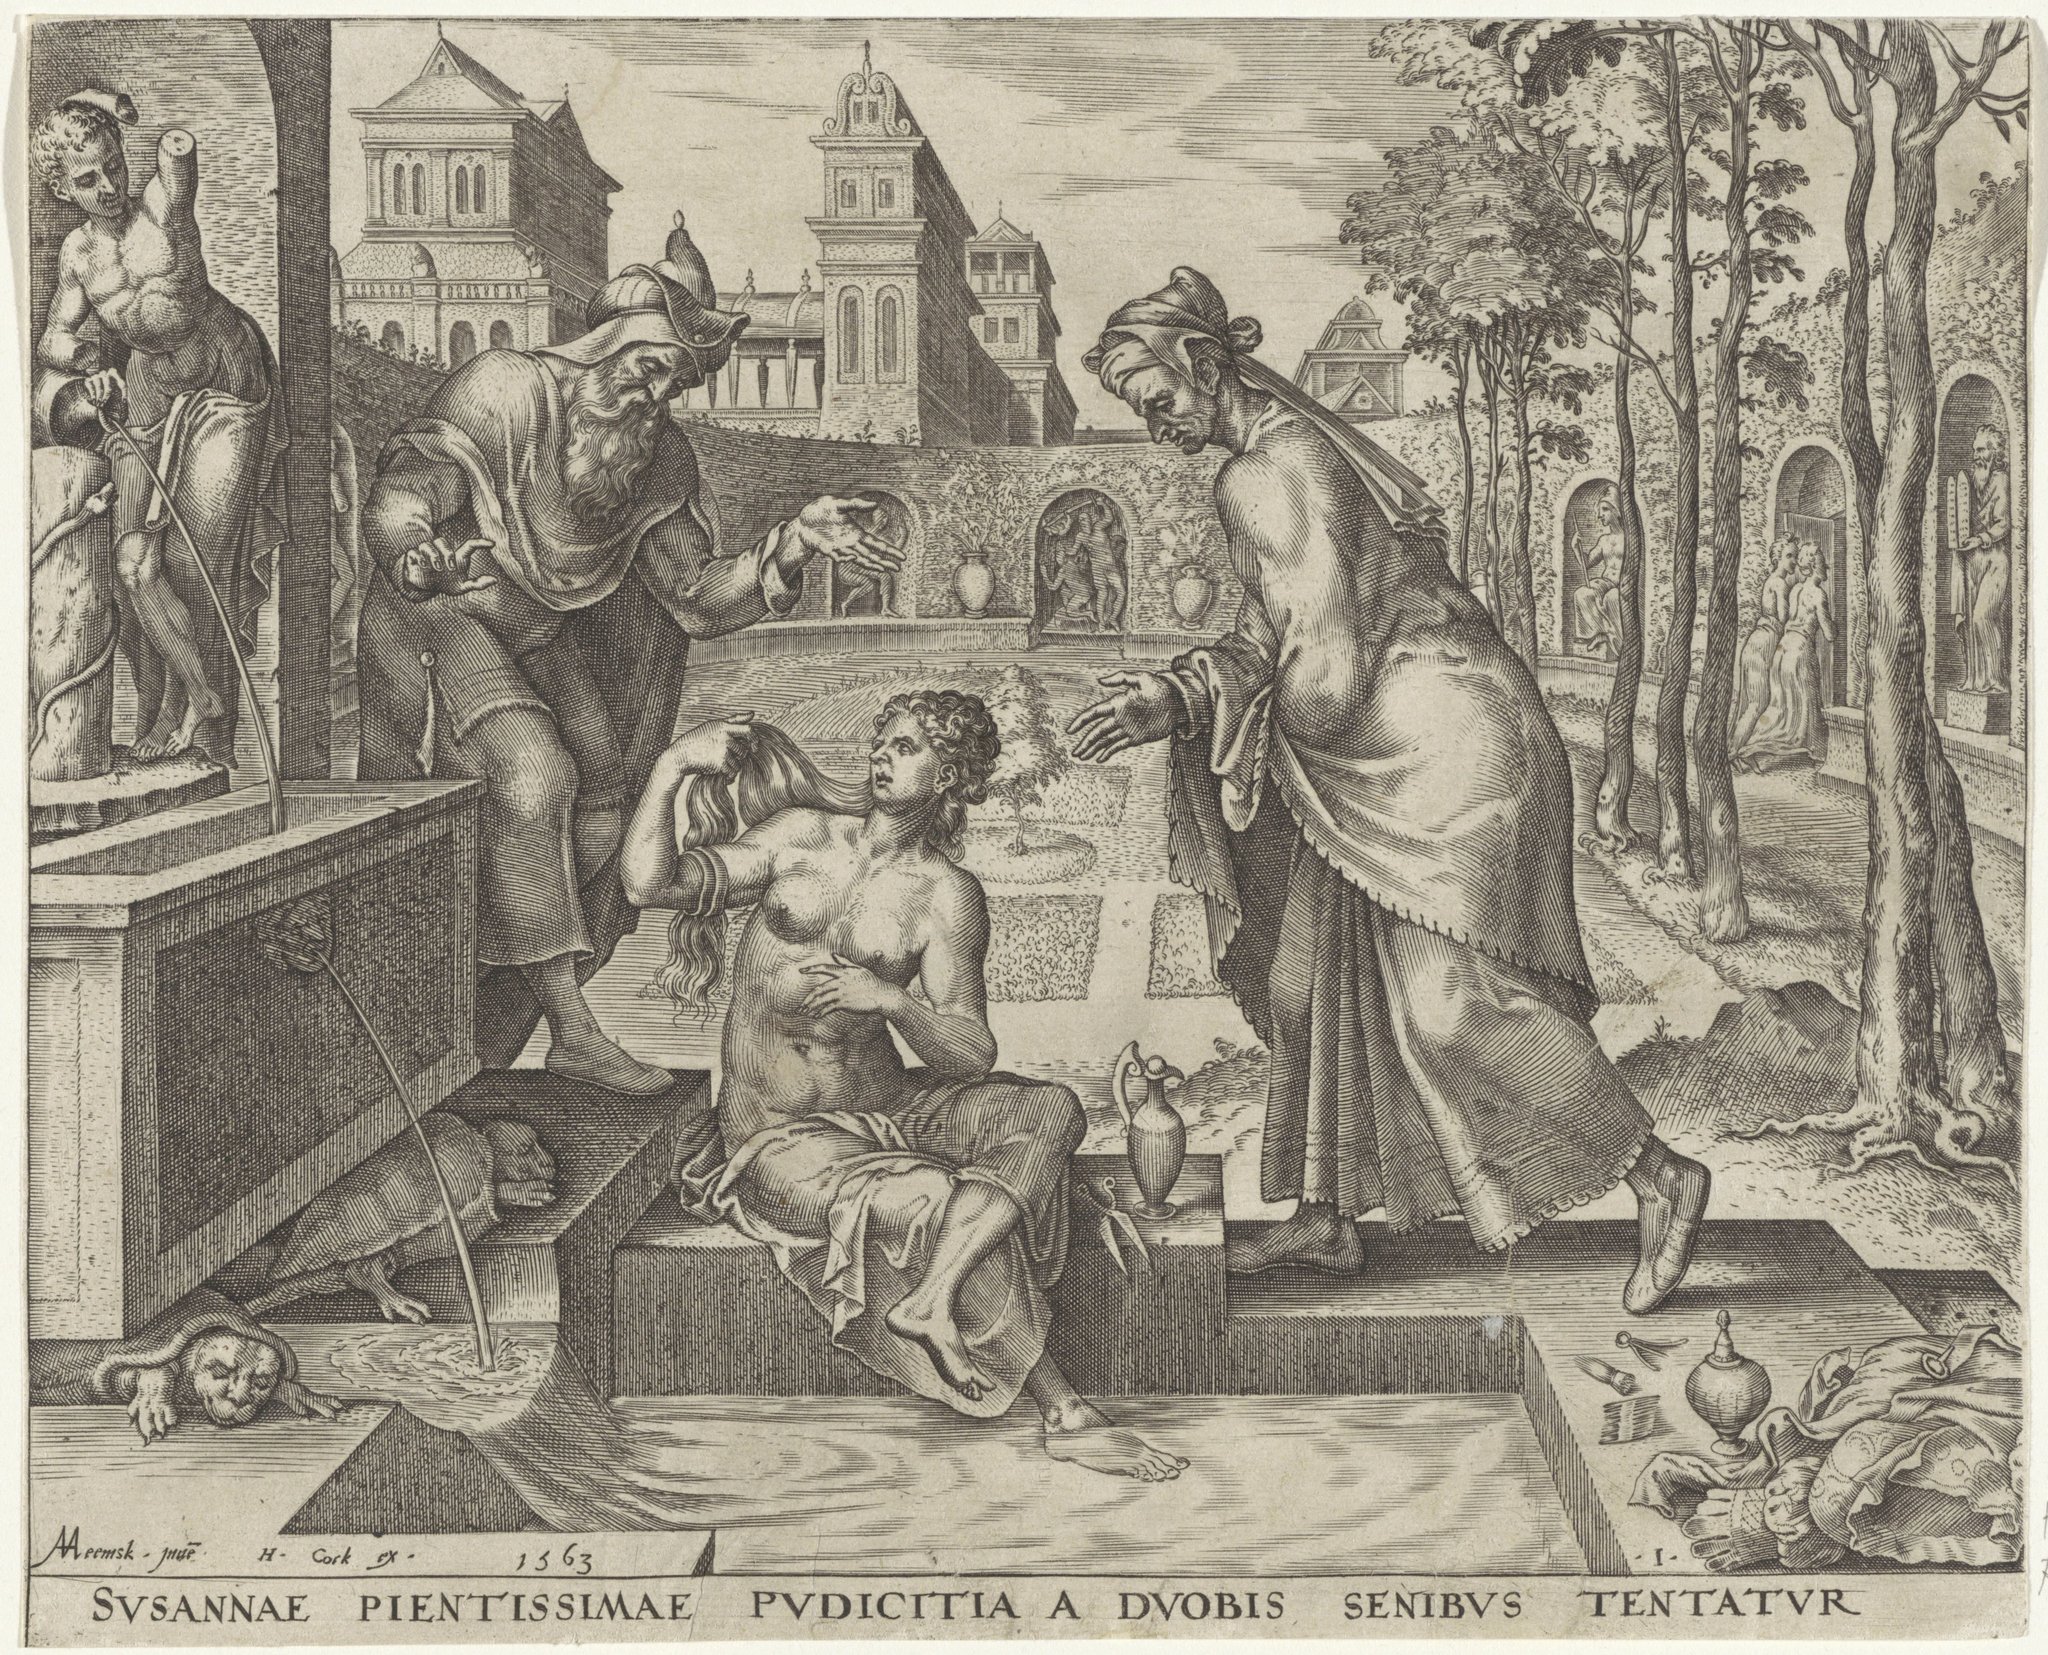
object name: print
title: Ouderlingen proberen Susanna te verleiden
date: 1563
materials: paper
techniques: engraving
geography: antwerp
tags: the elders making advances towards susanna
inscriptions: collector's mark: Lugt 2760, collector's mark: Lugt 2228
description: Susanna baadt bij een fontein in een tuin. Twee ouderlingen komen op haar af en proberen haar te verleiden. Bij de fontein liggen enkele verzorgingsproducten. Op de achtergrond een groot gebouw. Onderaan in de marge een éénregelig onderschrift in het Latijn.